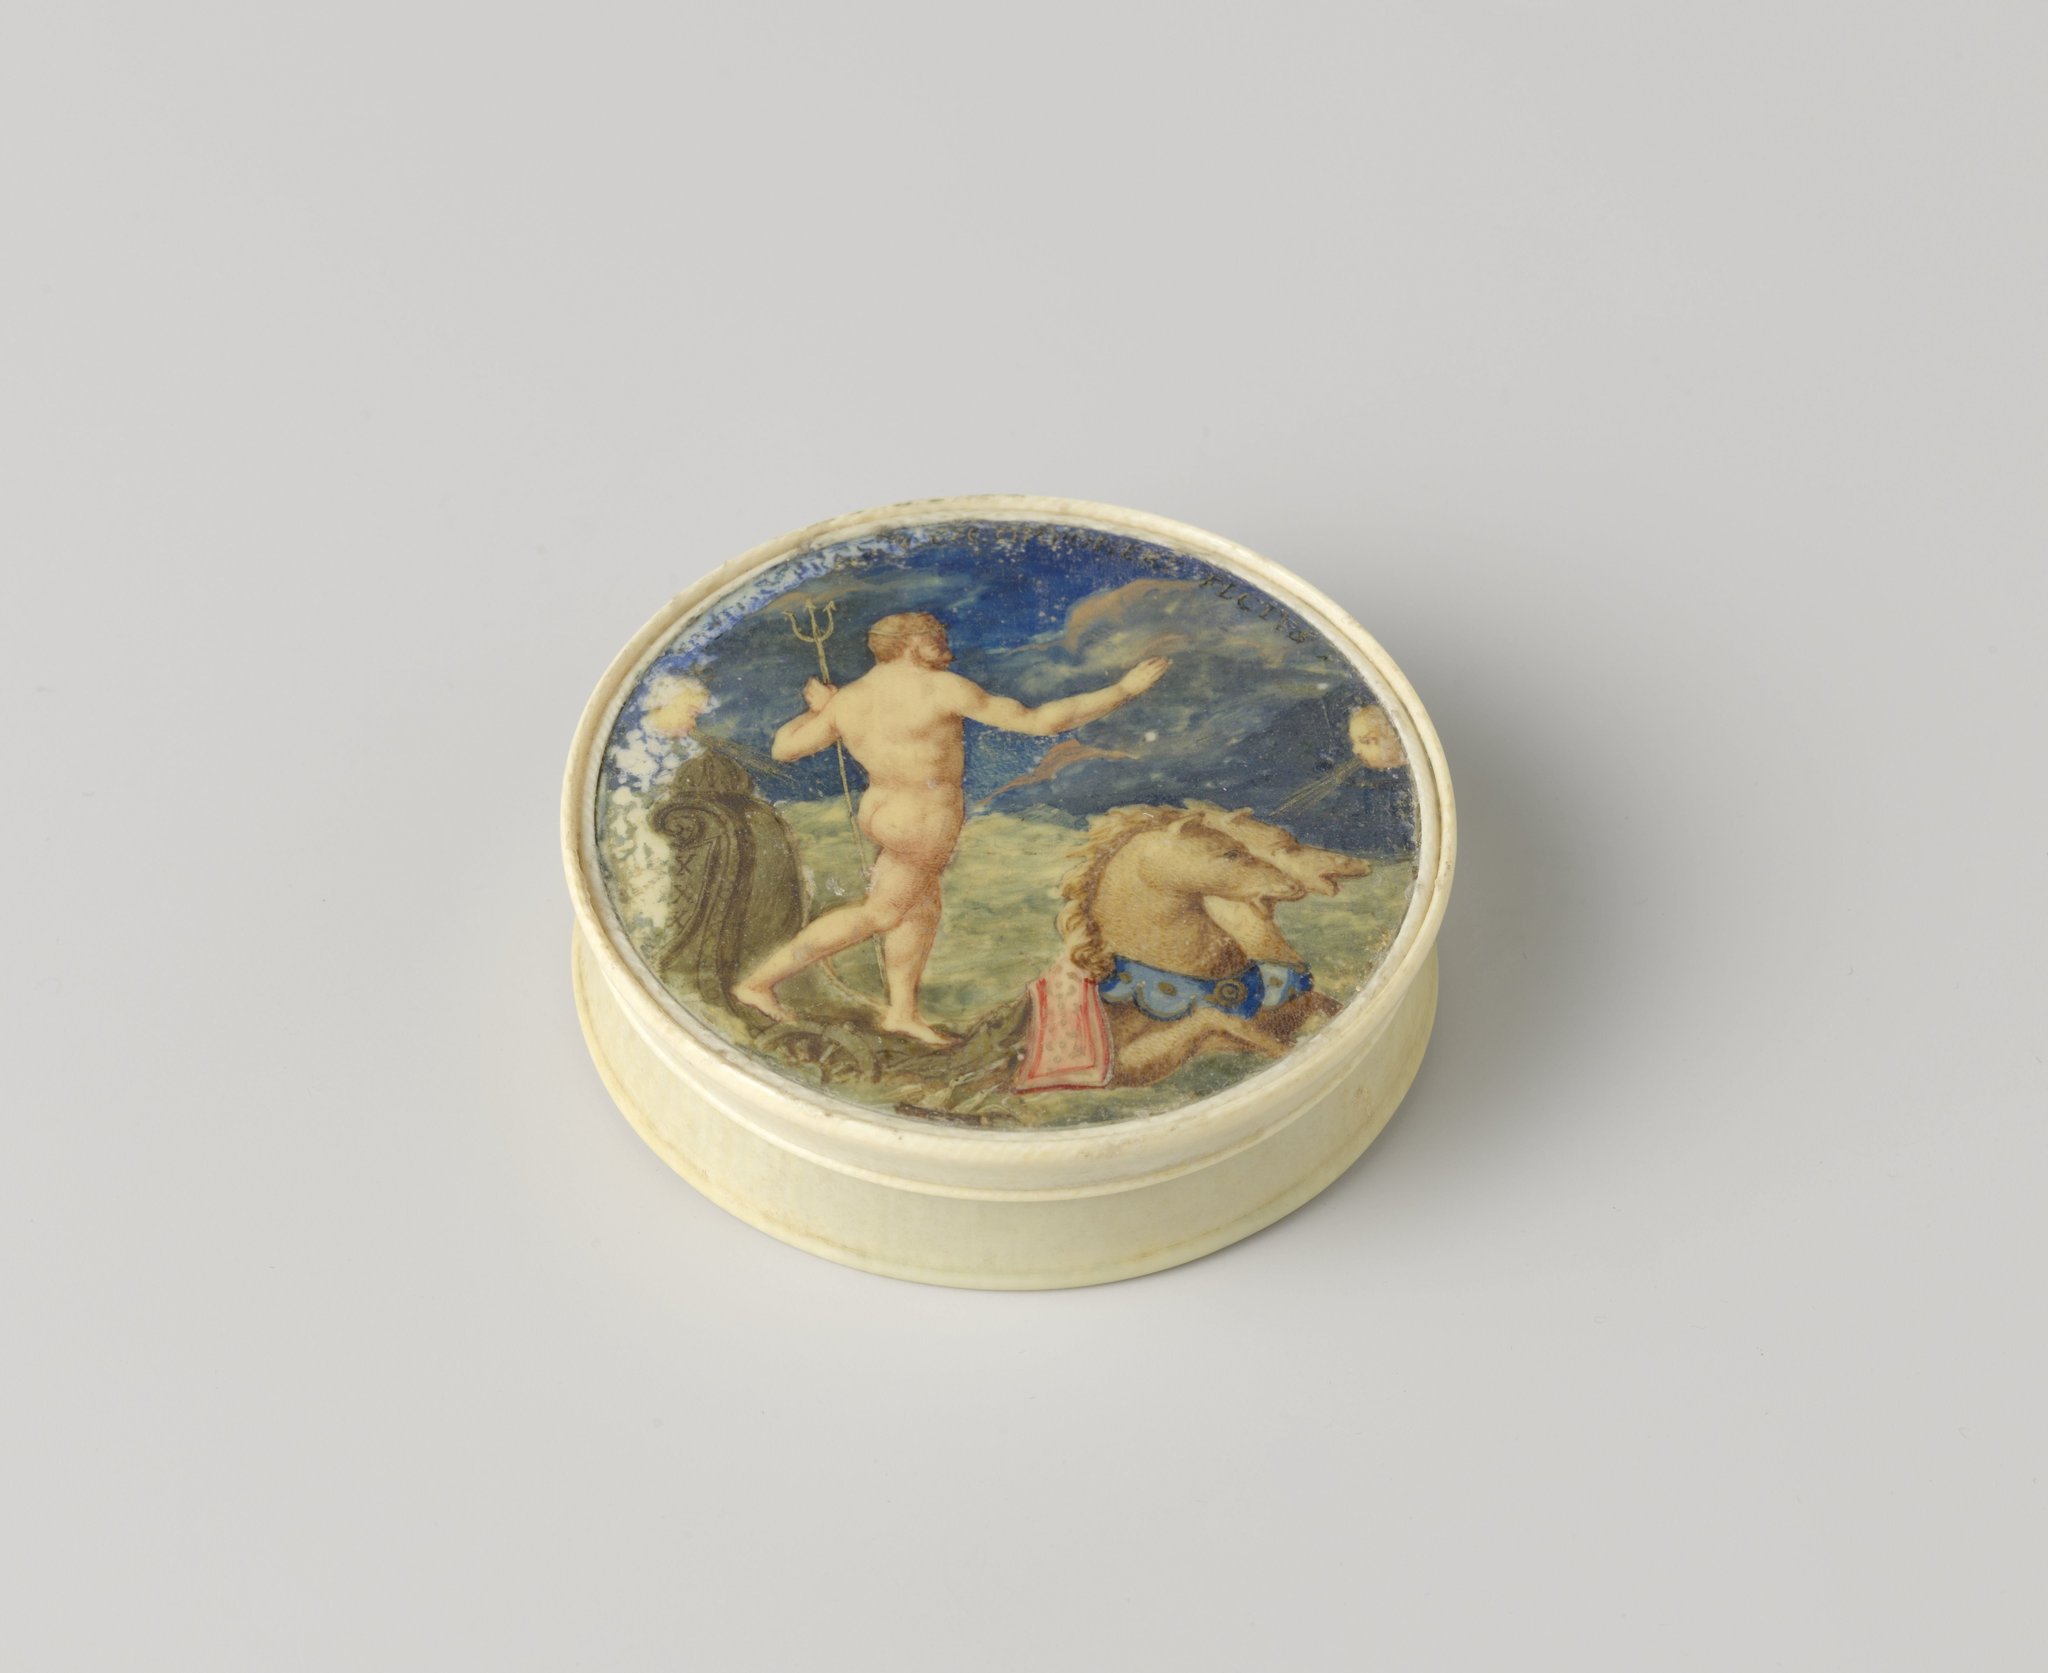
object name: box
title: Ivoren doosje met een miniatuur van Neptunus die de golven tot bedaren brengt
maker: Anonymous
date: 1696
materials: ivory, paint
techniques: painted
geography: amsterdam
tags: amsterdam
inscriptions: inscription: ‘In deze doos werd door de Regering der Stad Amsterdam aan hen die (waarschijnlijk ter walvischvaart) naar de IJszee waren geweest en vandaar teruggekomen een geschenk aangeboden, misschien een medaille, een geschenk in geld of een te brief. Op het deksel staat: De Regering der Stad Amsterdam heeft aan hare burgers, die uit het Noorden zijn teruggekeerd, uit aanmerking van hunne meermalen aan den dag gelegde onverschrokkenheid en hunne beproefde trouw, dit geschenk vereerd. 1696 ... Hij (Neptunus de God en beheerscher der Zee) beyvert zich om de golven der zee tot bedaren te brengen. No. 86’, inscription: ‘... praestat componere flctus / ... onibus redugt natus Amstelod civibus quis hoc antique virtutis ... s.ectataeq fidei praemium largitur MDC XC VI’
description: Rond ivoren doosje met een aan beide zijden beschilderde deksel. Buitenzijde: naakte man met in linkerhand drietand en rechterhand naar voren wijzend (Neptunus), naar rechts staande op een wagen met aan achterzijde wapen (van Amsterdam), getrokken door 2 paarden op zee, met l. en r. 2 blazende gezichten; aan bovenrand tekst. Binnenkant: bovenste gedeelte tekst, (zie opschrift). daaronder voorstelling: onder- of opgaande zon met linksonder klein scheepje. De voorstelling van Neptunus bedaart de zee is overgenomen van een penning geslagen door de stad Amsterdam in 1696.